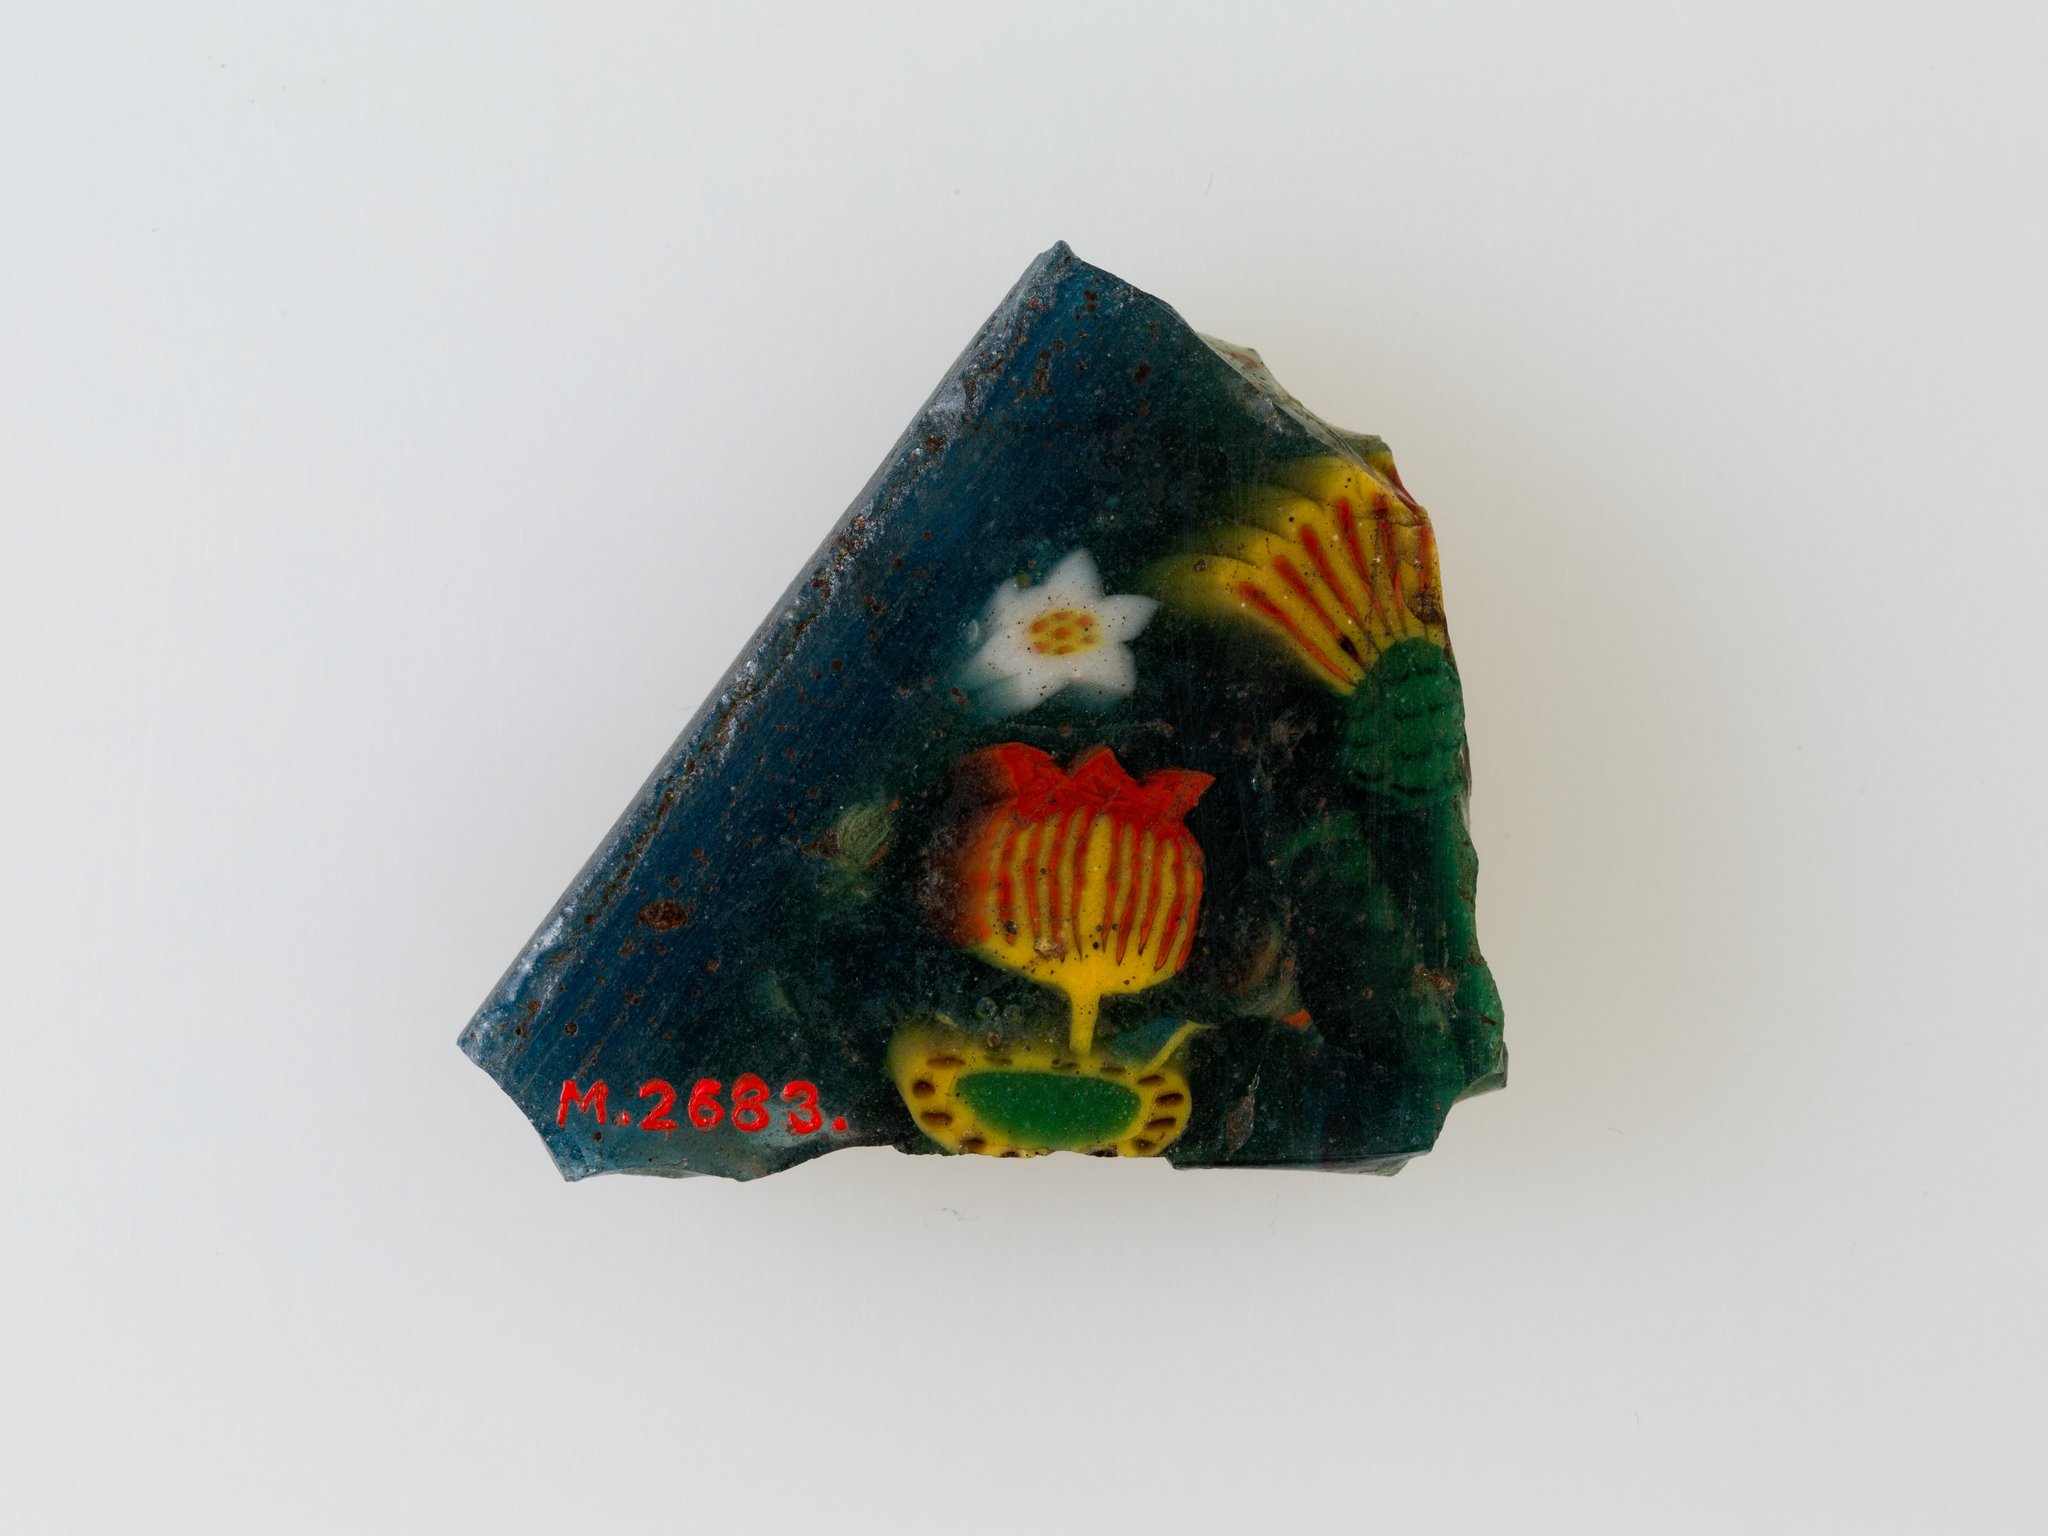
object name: plaque, floral, inlay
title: Floral plaque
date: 100 BCE-100 CE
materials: glass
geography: egypt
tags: flowers